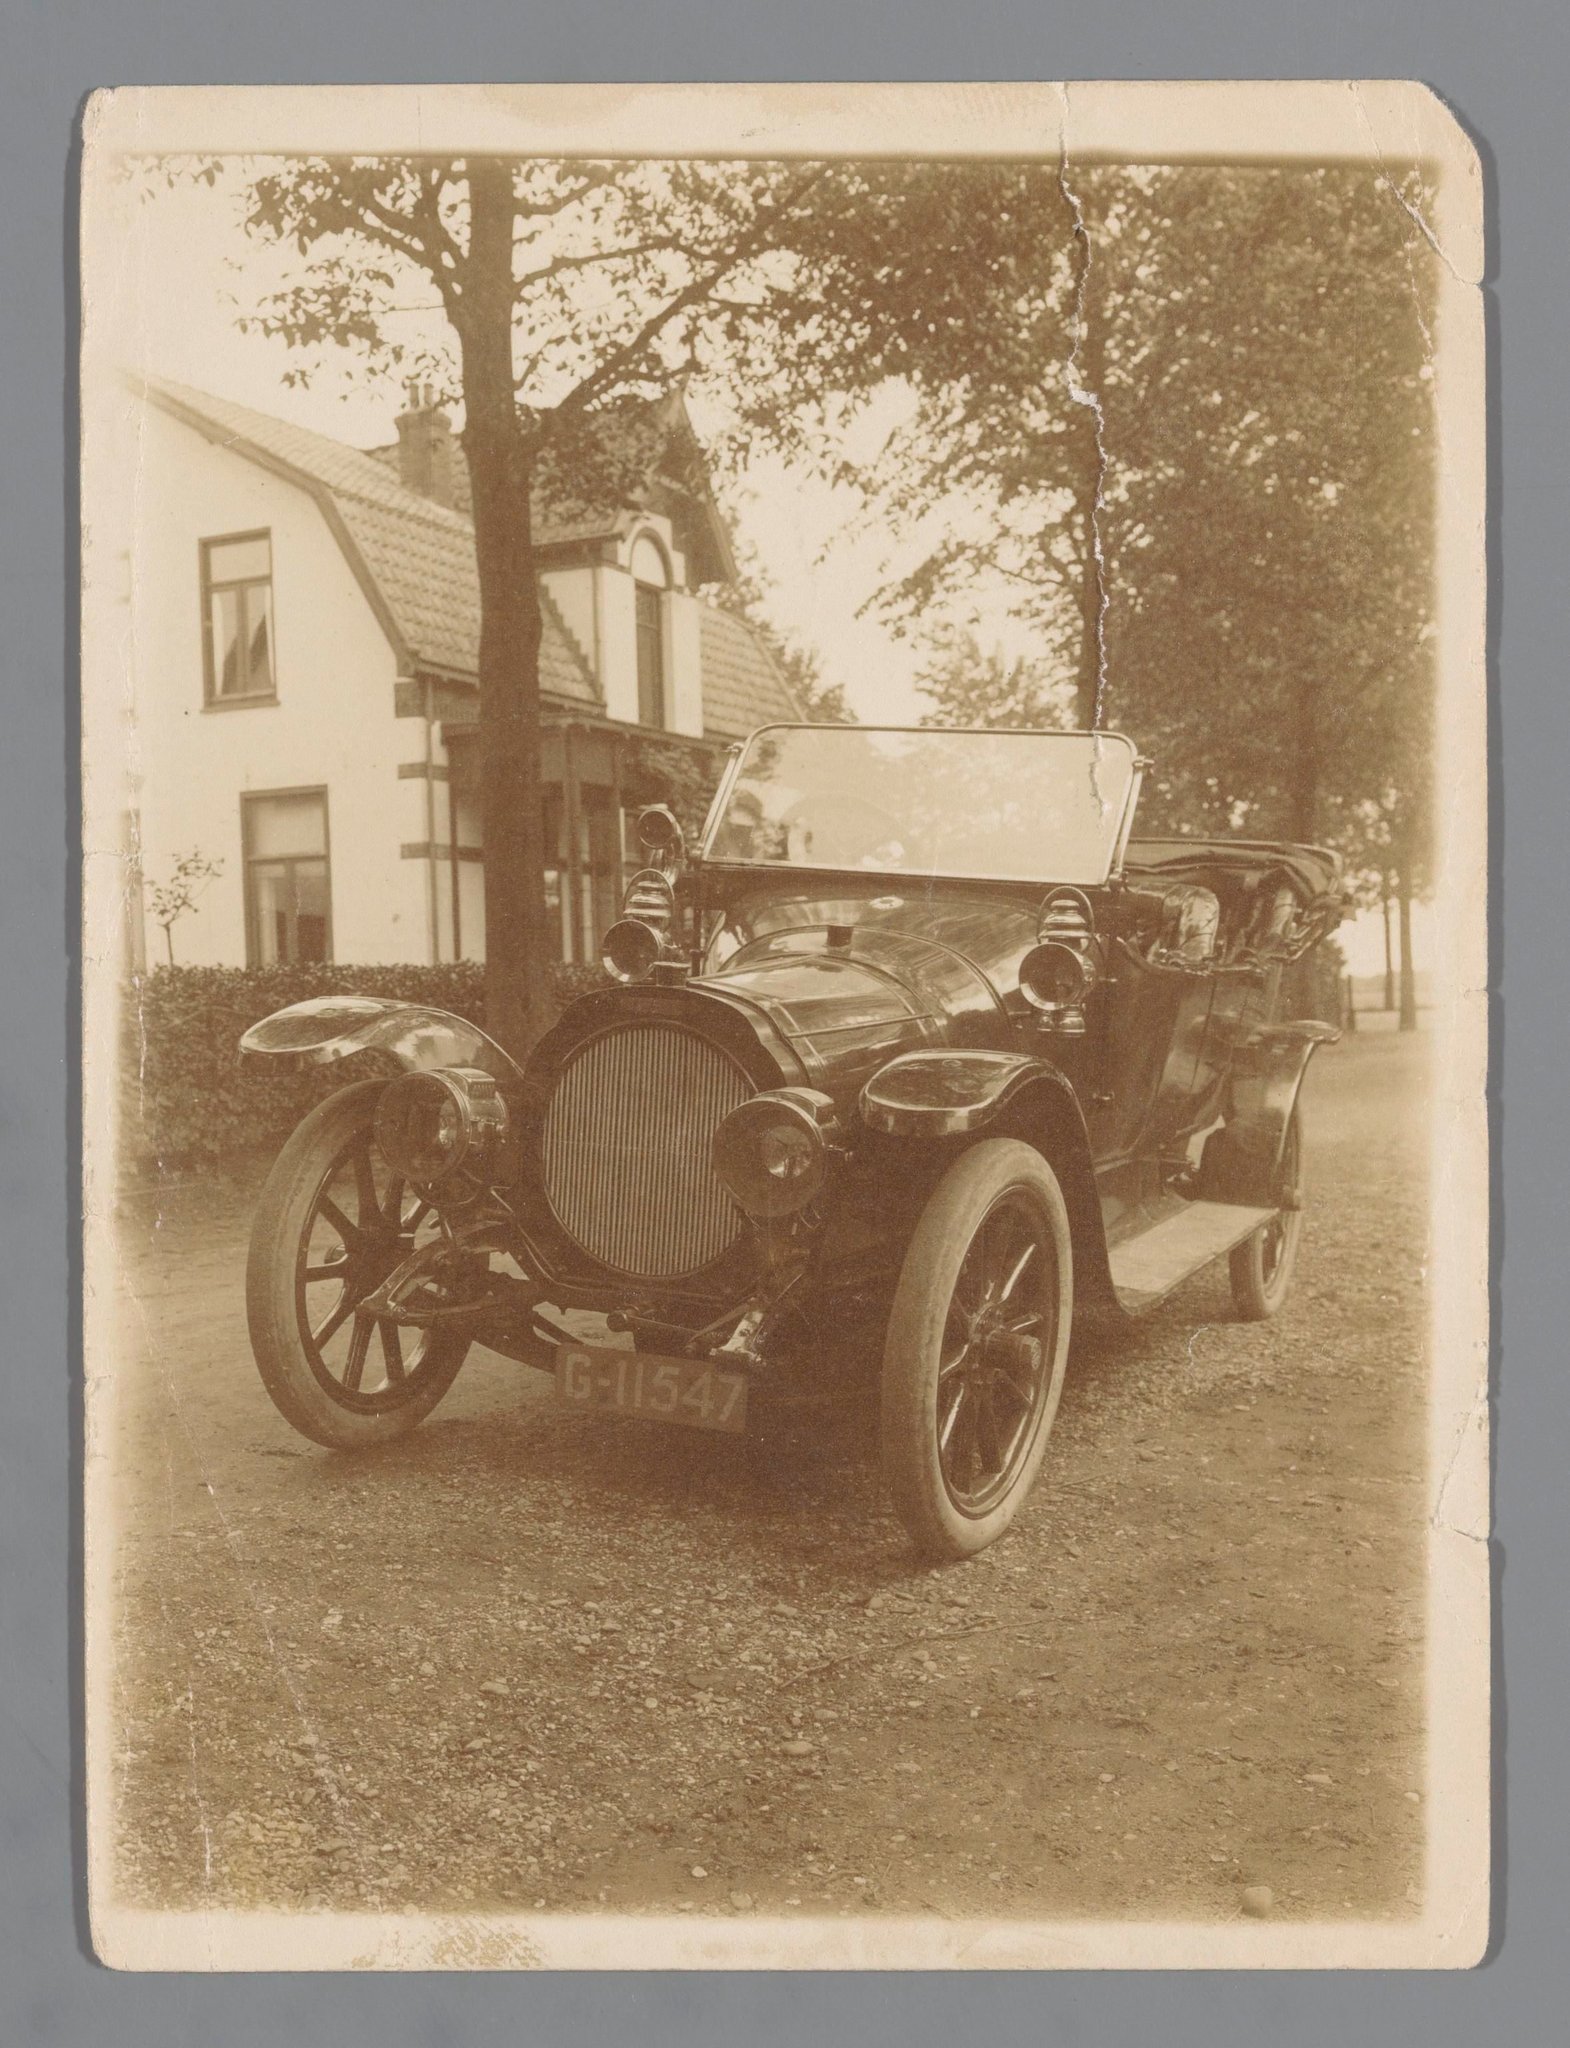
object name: photograph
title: Auto voor een woning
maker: Anonymous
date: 1919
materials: photographic support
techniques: gelatin silver print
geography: netherlands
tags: façade (of house or building), automobile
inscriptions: inscription: ‘1919.’